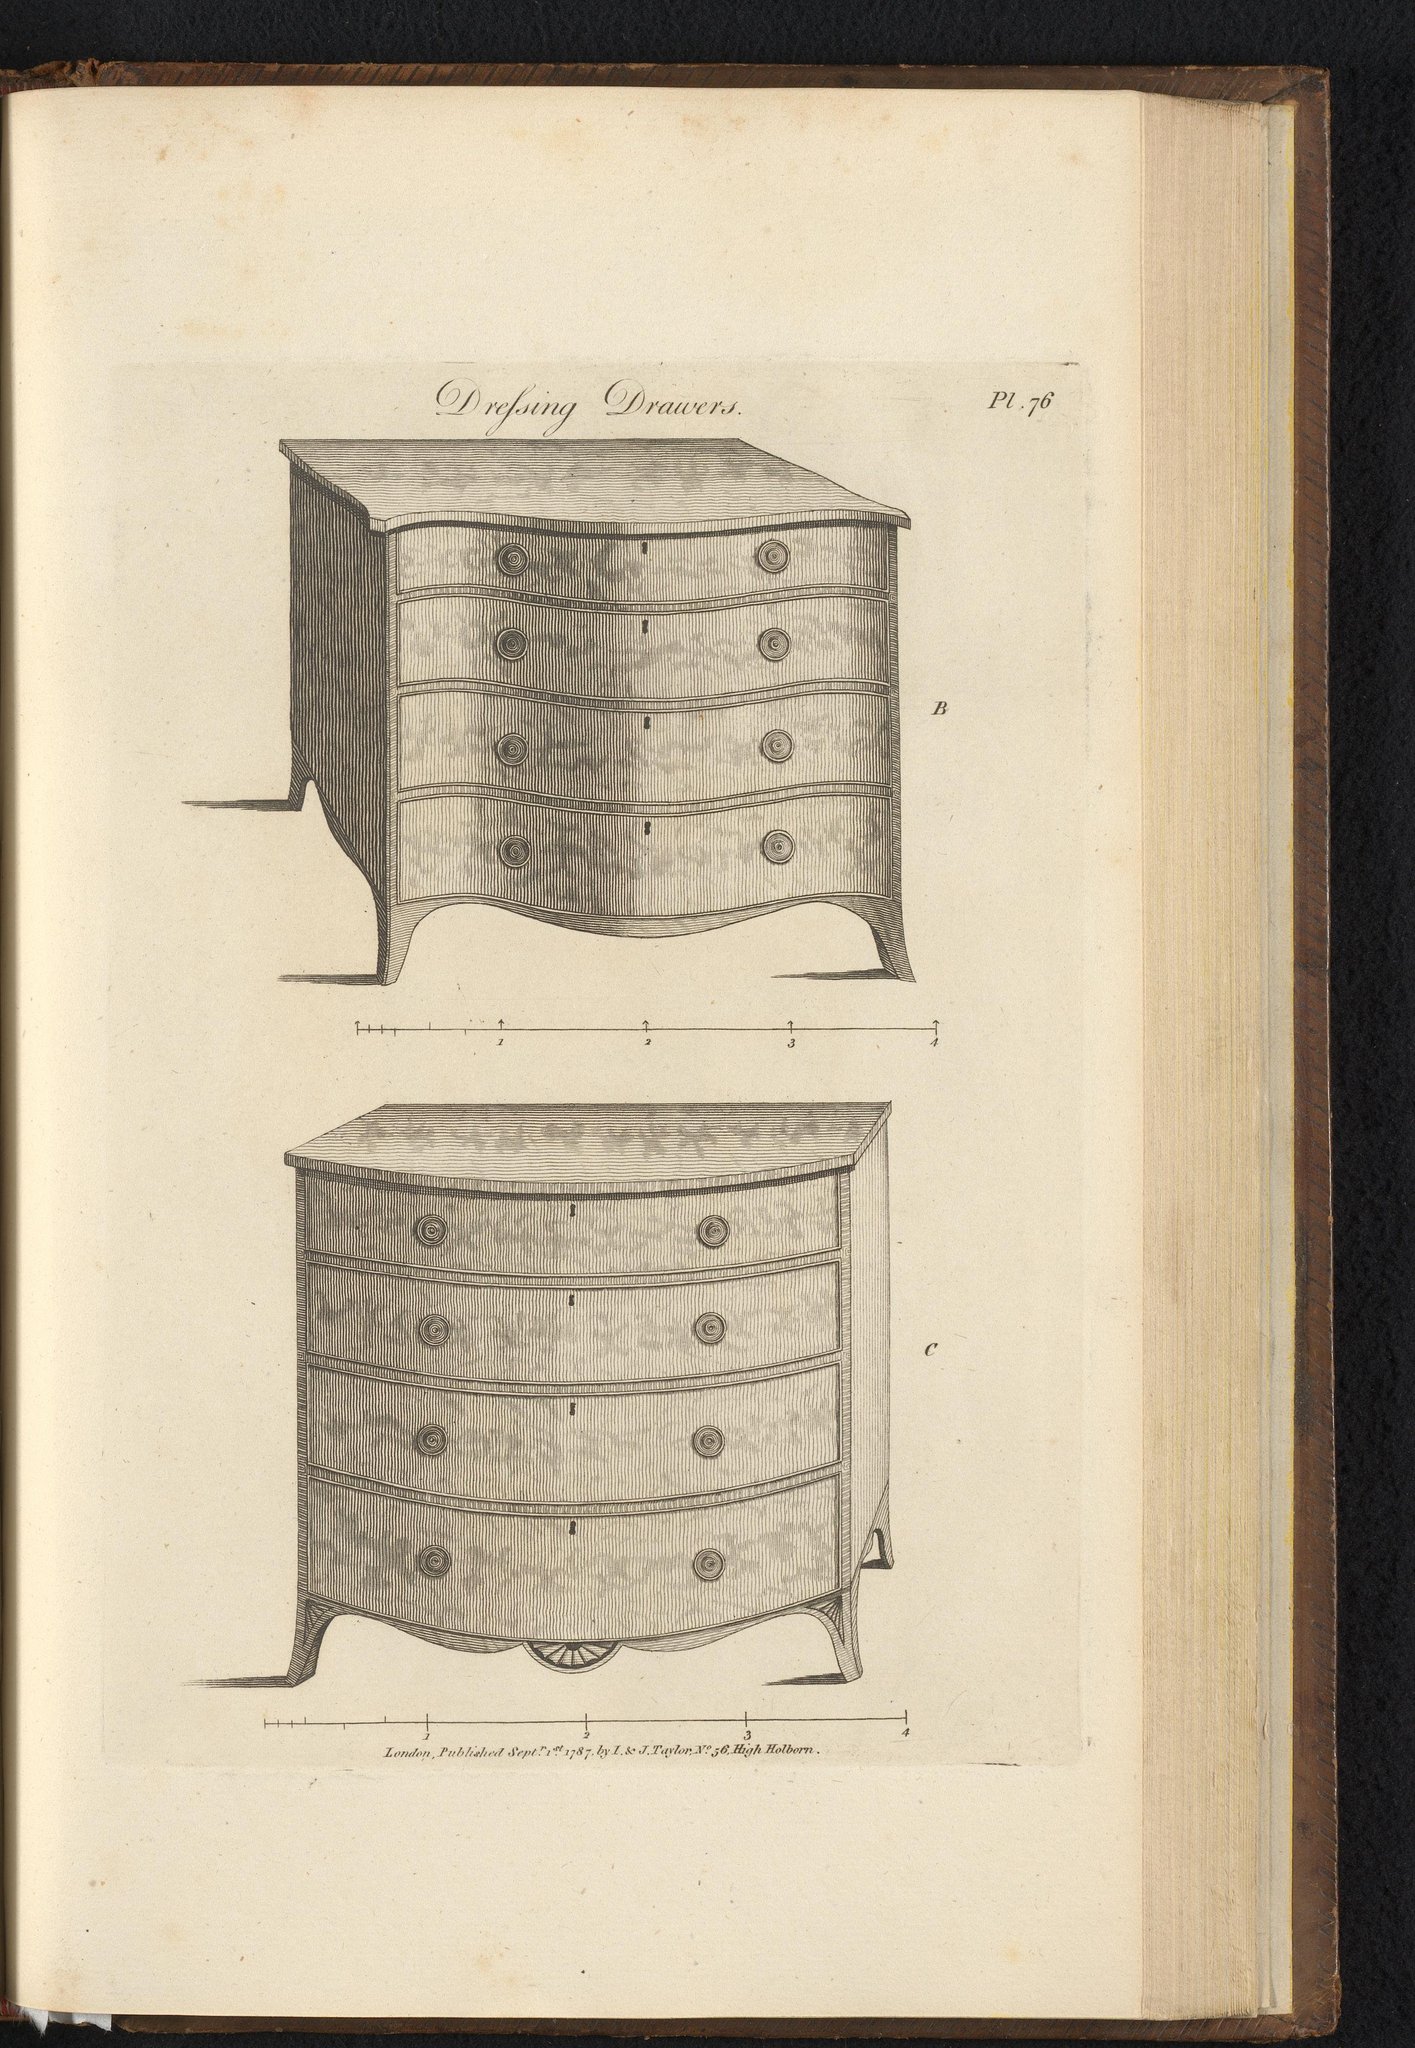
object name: page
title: Dressing Drawers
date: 1787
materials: paper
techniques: engraving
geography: holborn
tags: table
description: Genummerd: Pl. 76. Tafels gemerkt als: B en C. Schaalverdeling in de ondermarge. Prent maakt deel uit van een boek.